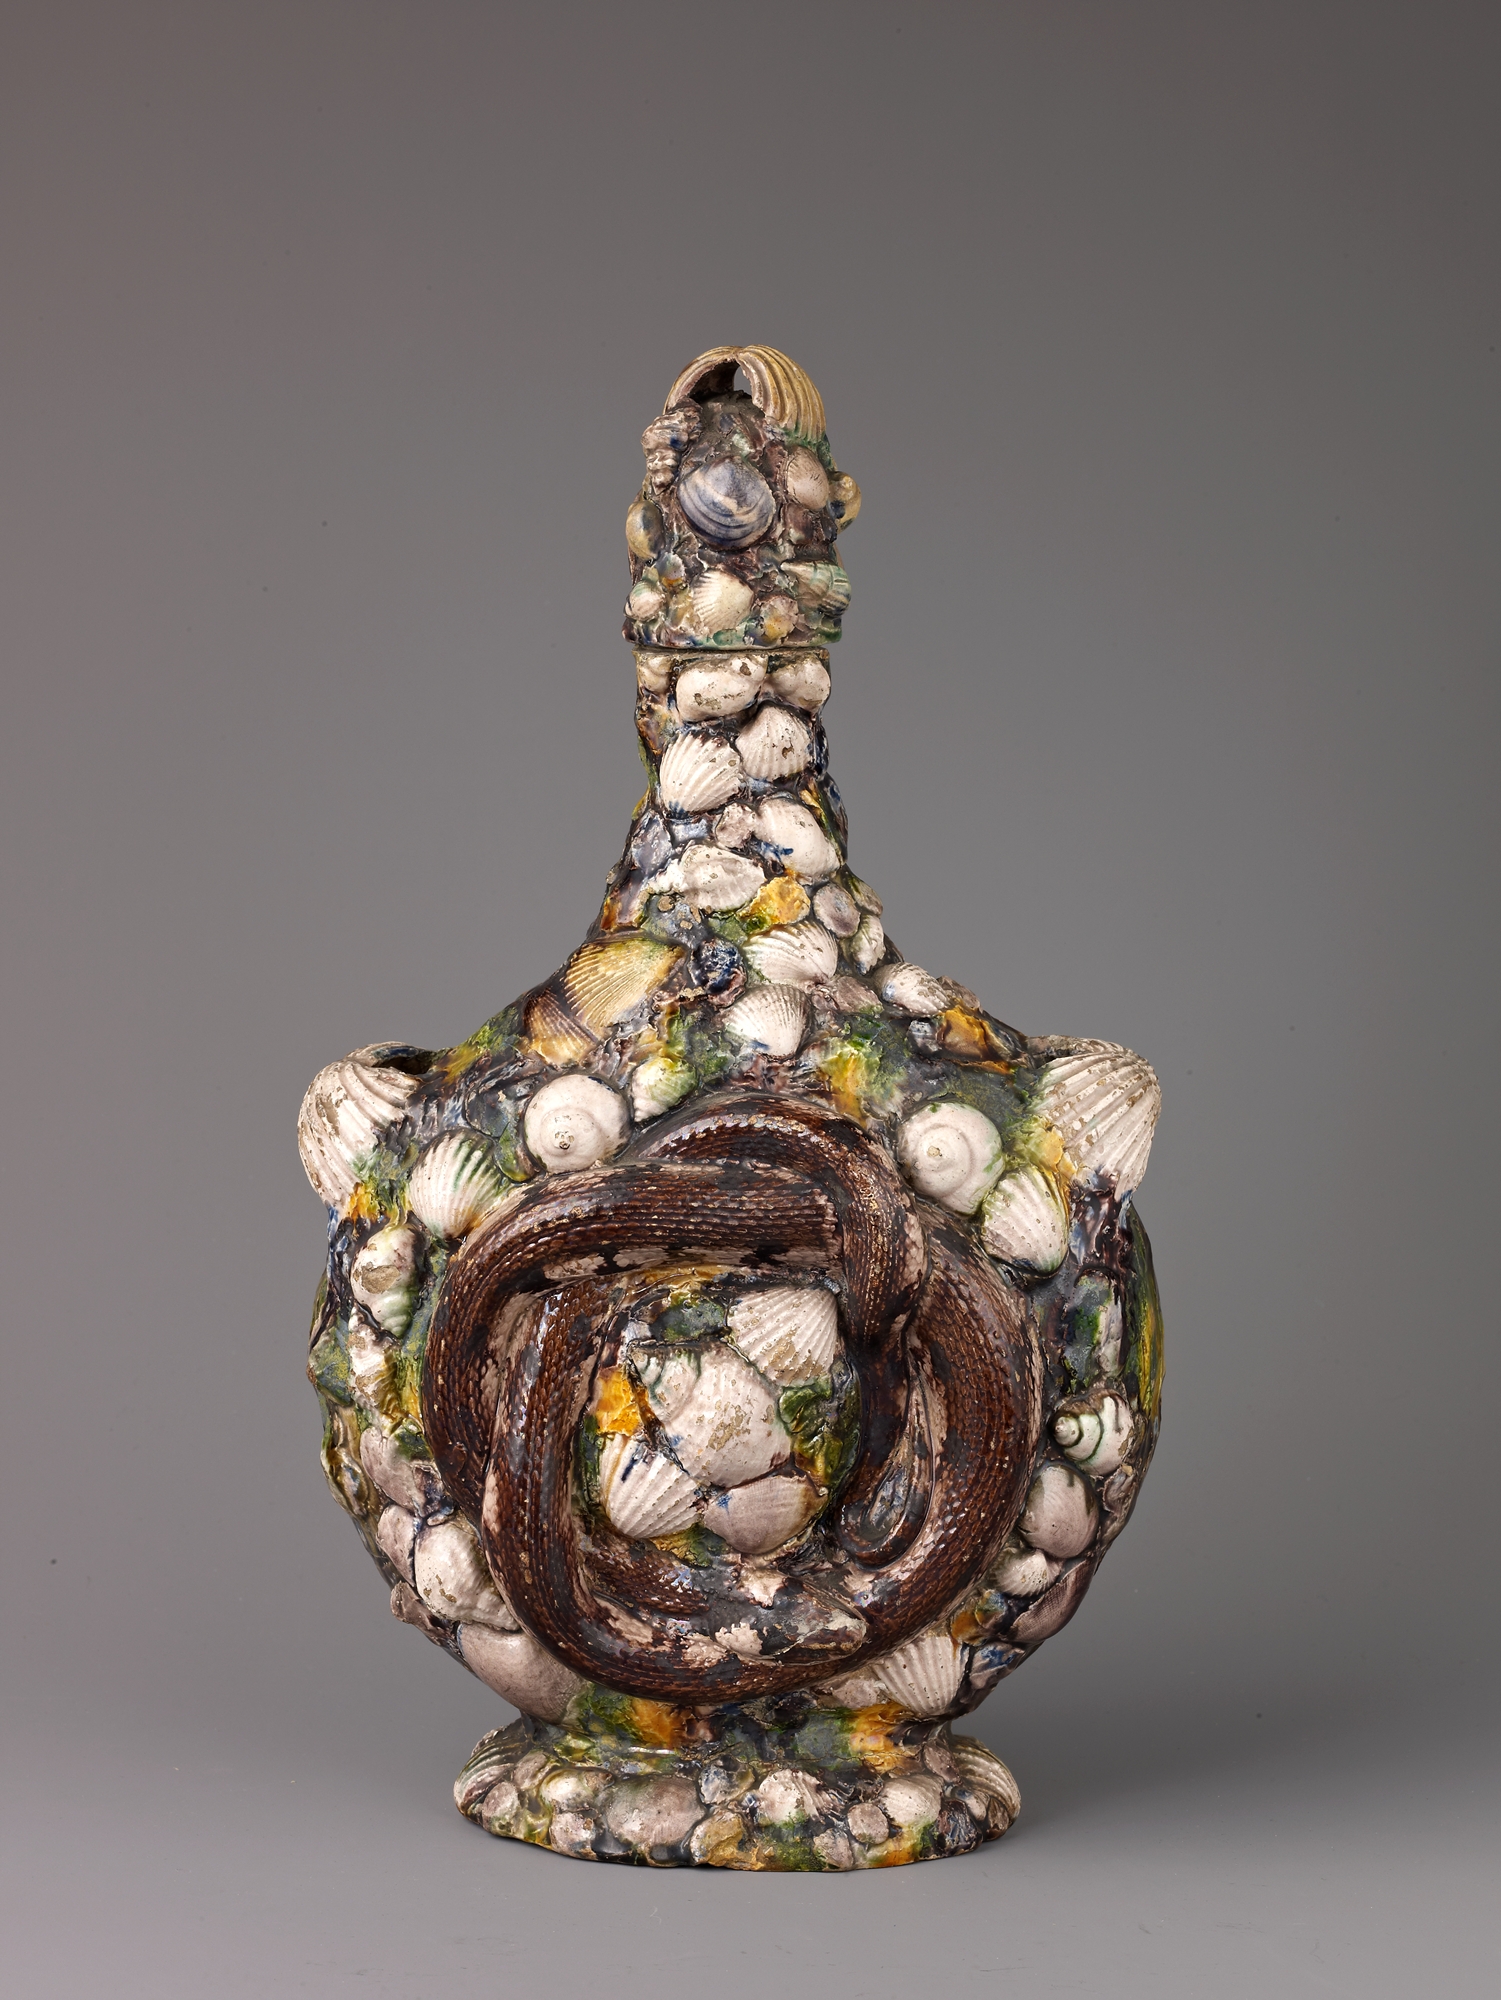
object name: pilgrim flask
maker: bernard palissy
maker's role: artist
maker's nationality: french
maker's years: 1510-1590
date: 1556-1567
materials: earthenware, glaze, lead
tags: snakes,shells